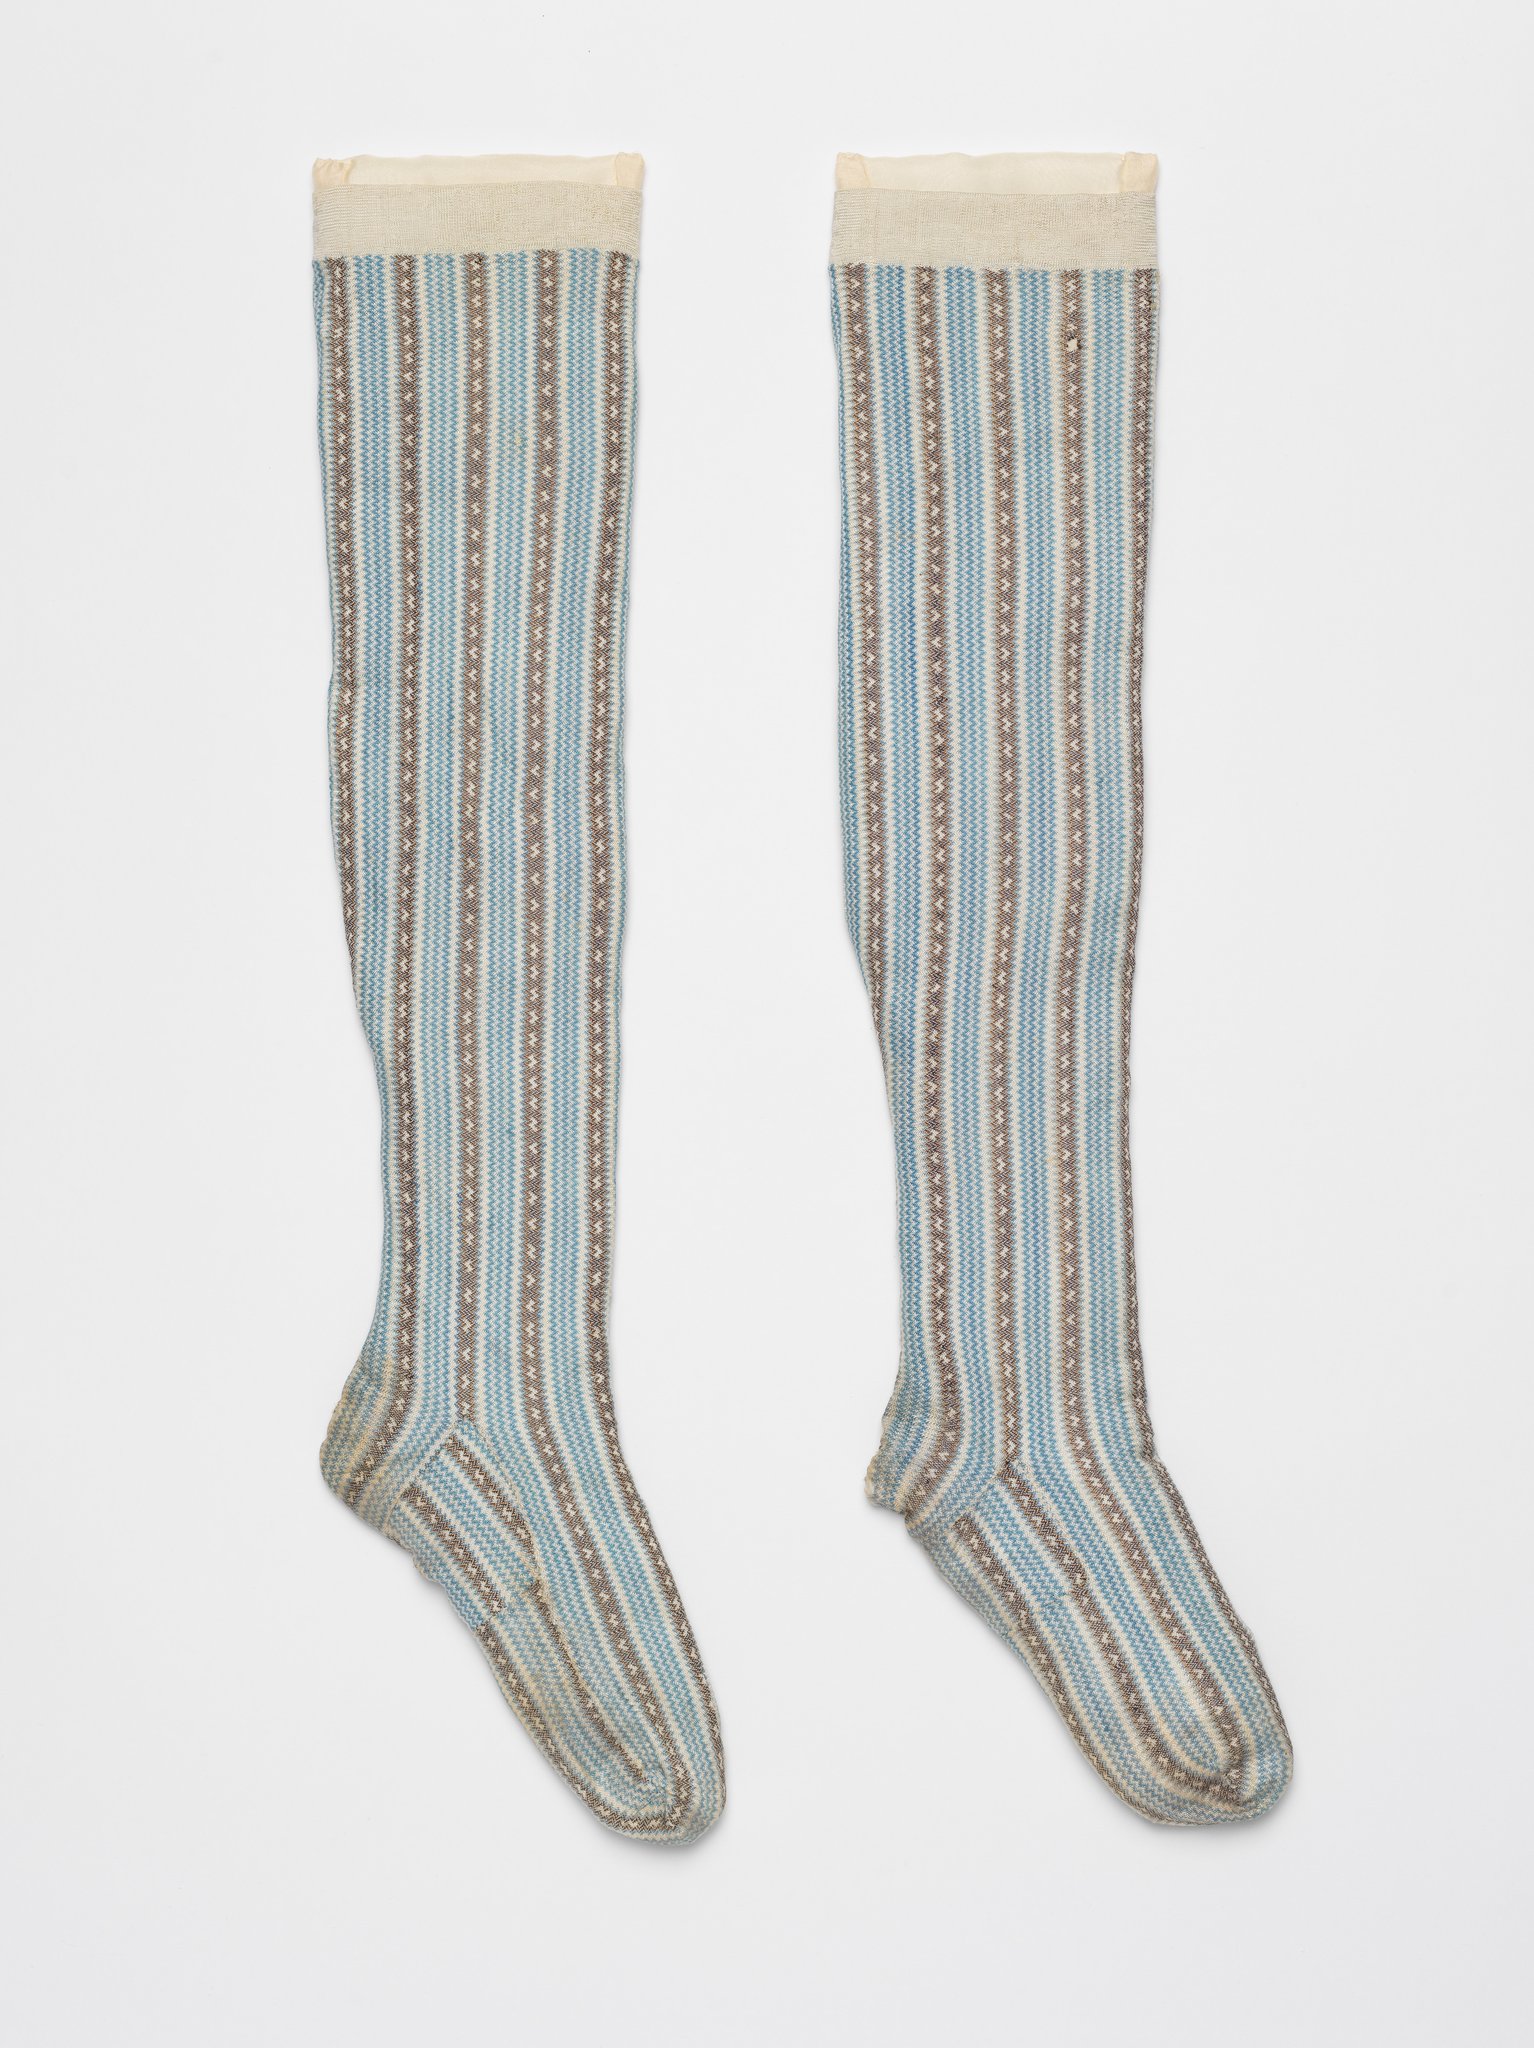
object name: stocking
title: Stockings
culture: french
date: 1775-1795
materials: silk